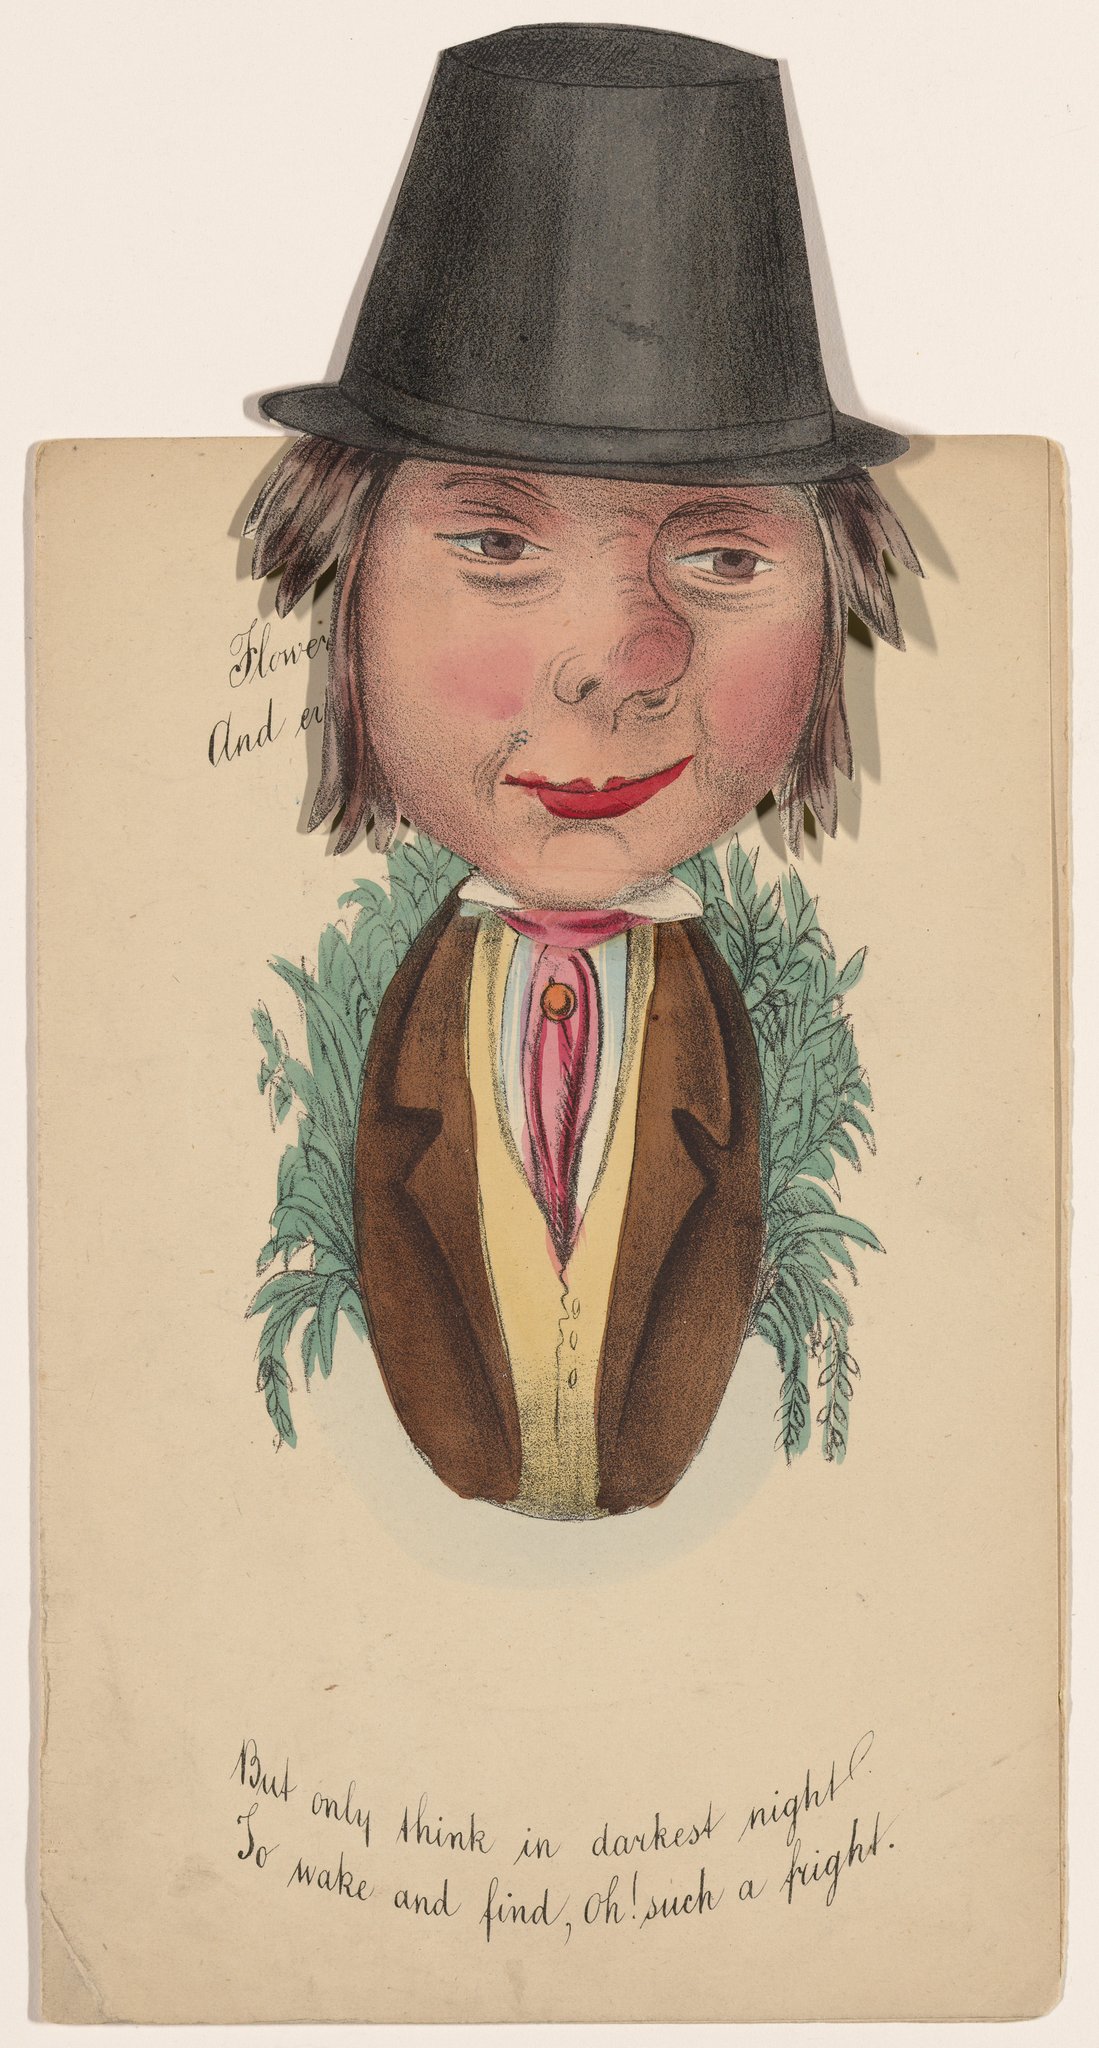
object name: valentine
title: Comic Valentine (funny man)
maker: Anonymous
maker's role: artist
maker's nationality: british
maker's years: 1800-1899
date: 1860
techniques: hand coloring, lithograph